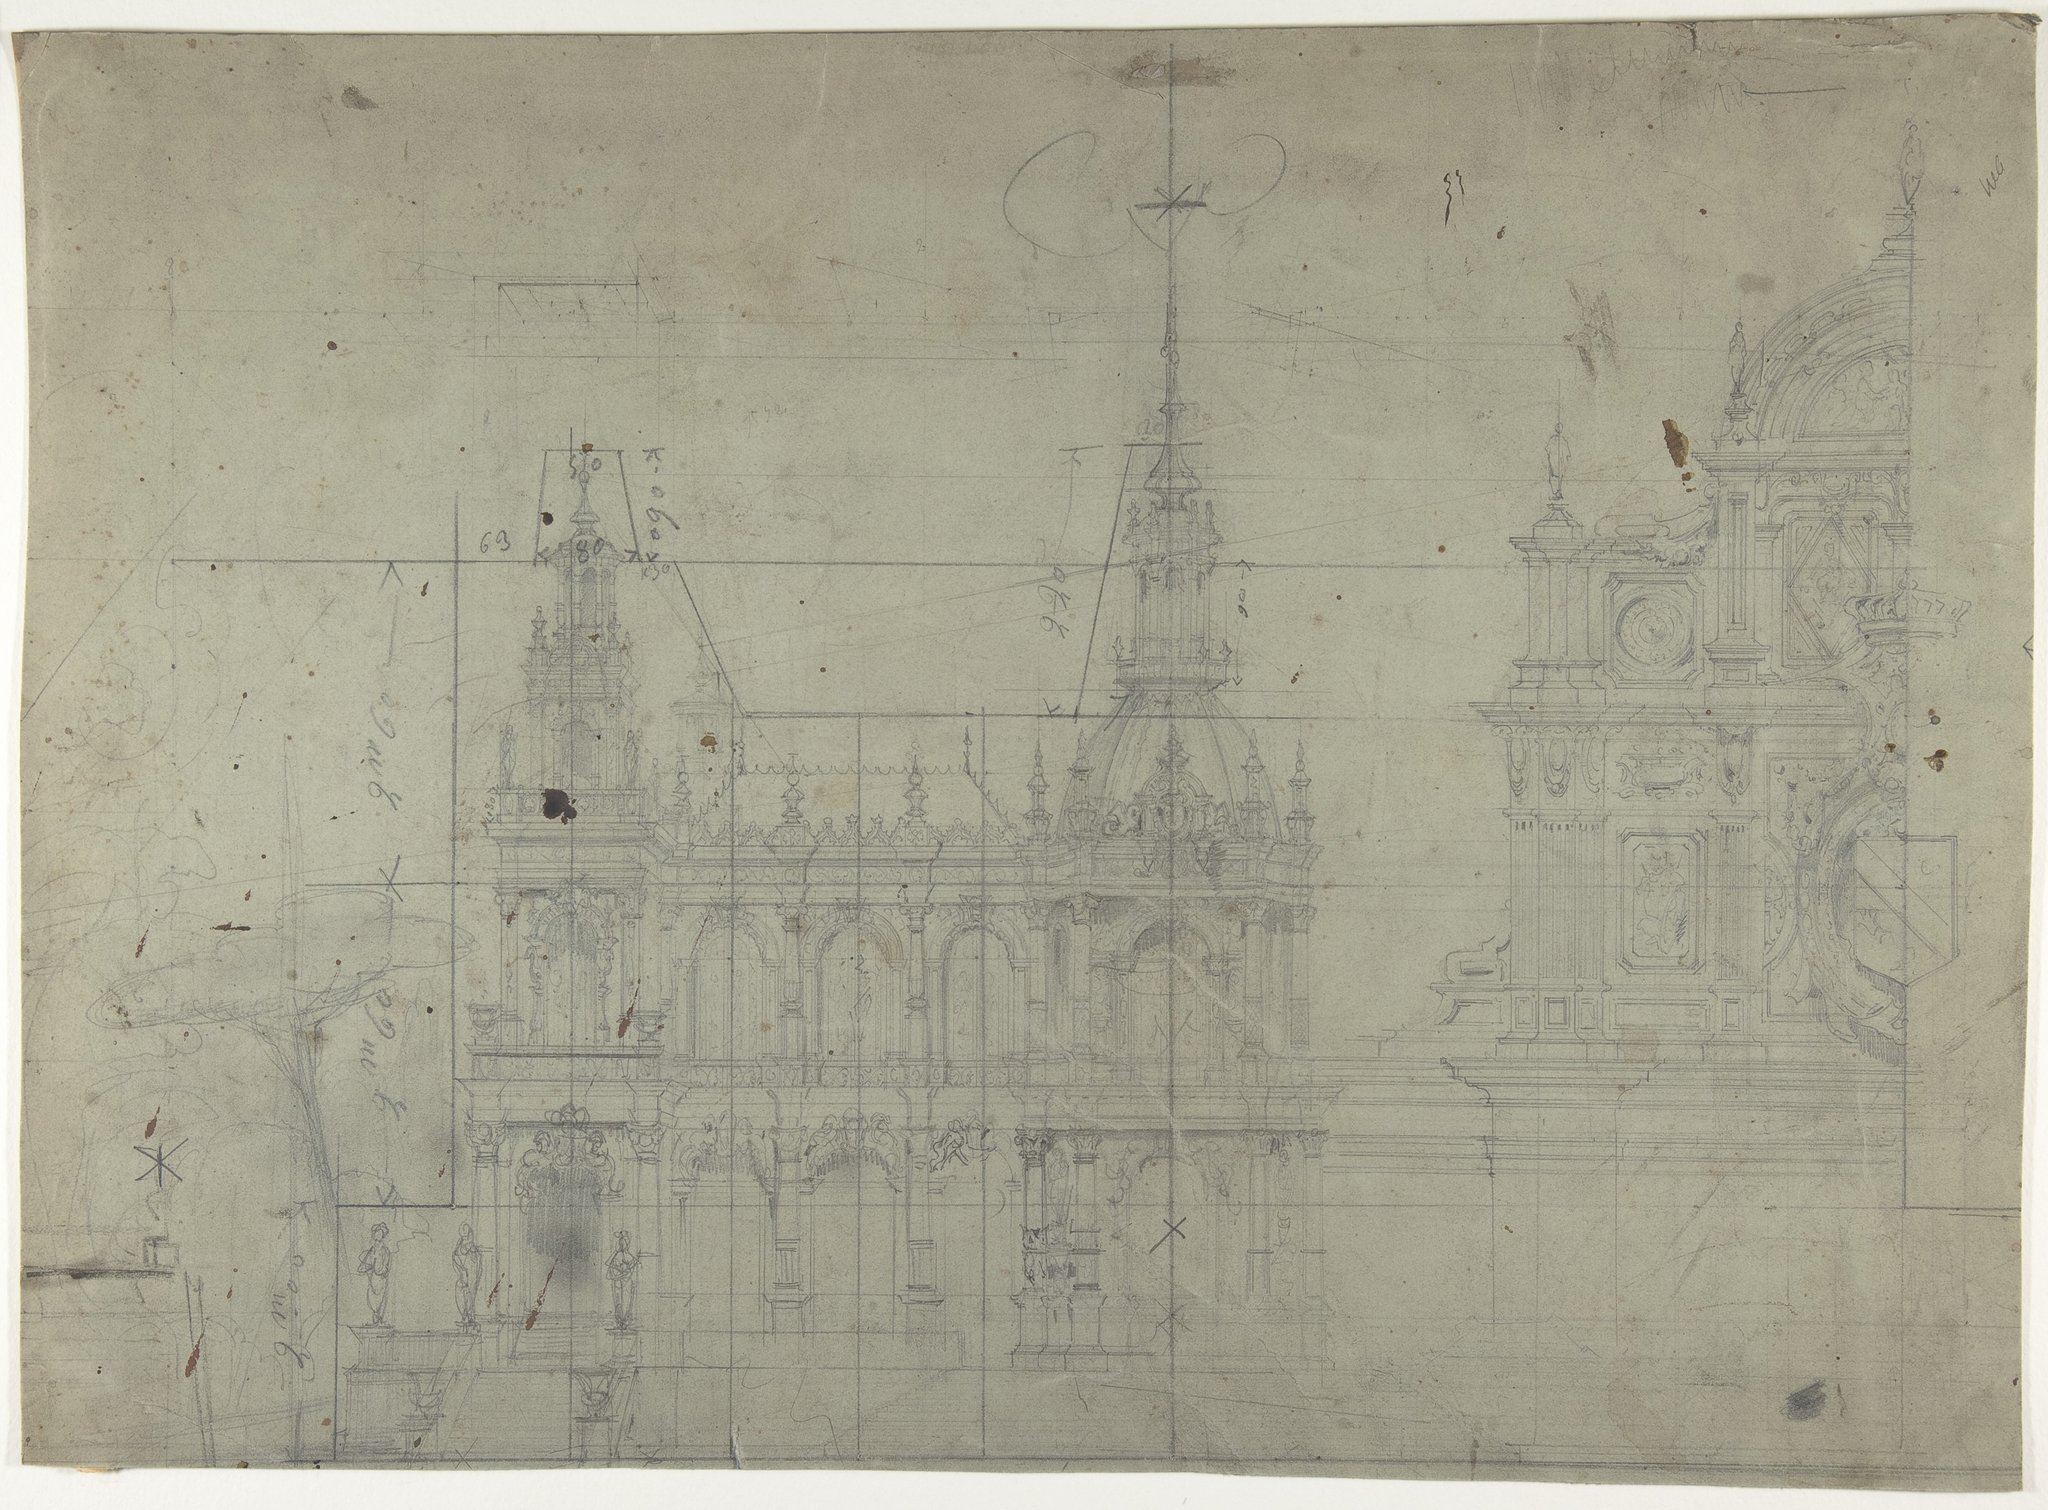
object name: drawing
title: Design for a Stage Set at the Opéra, Paris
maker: eugène cicéri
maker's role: artist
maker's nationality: french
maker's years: 1813-1890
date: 1830-1890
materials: graphite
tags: buildings,stage design